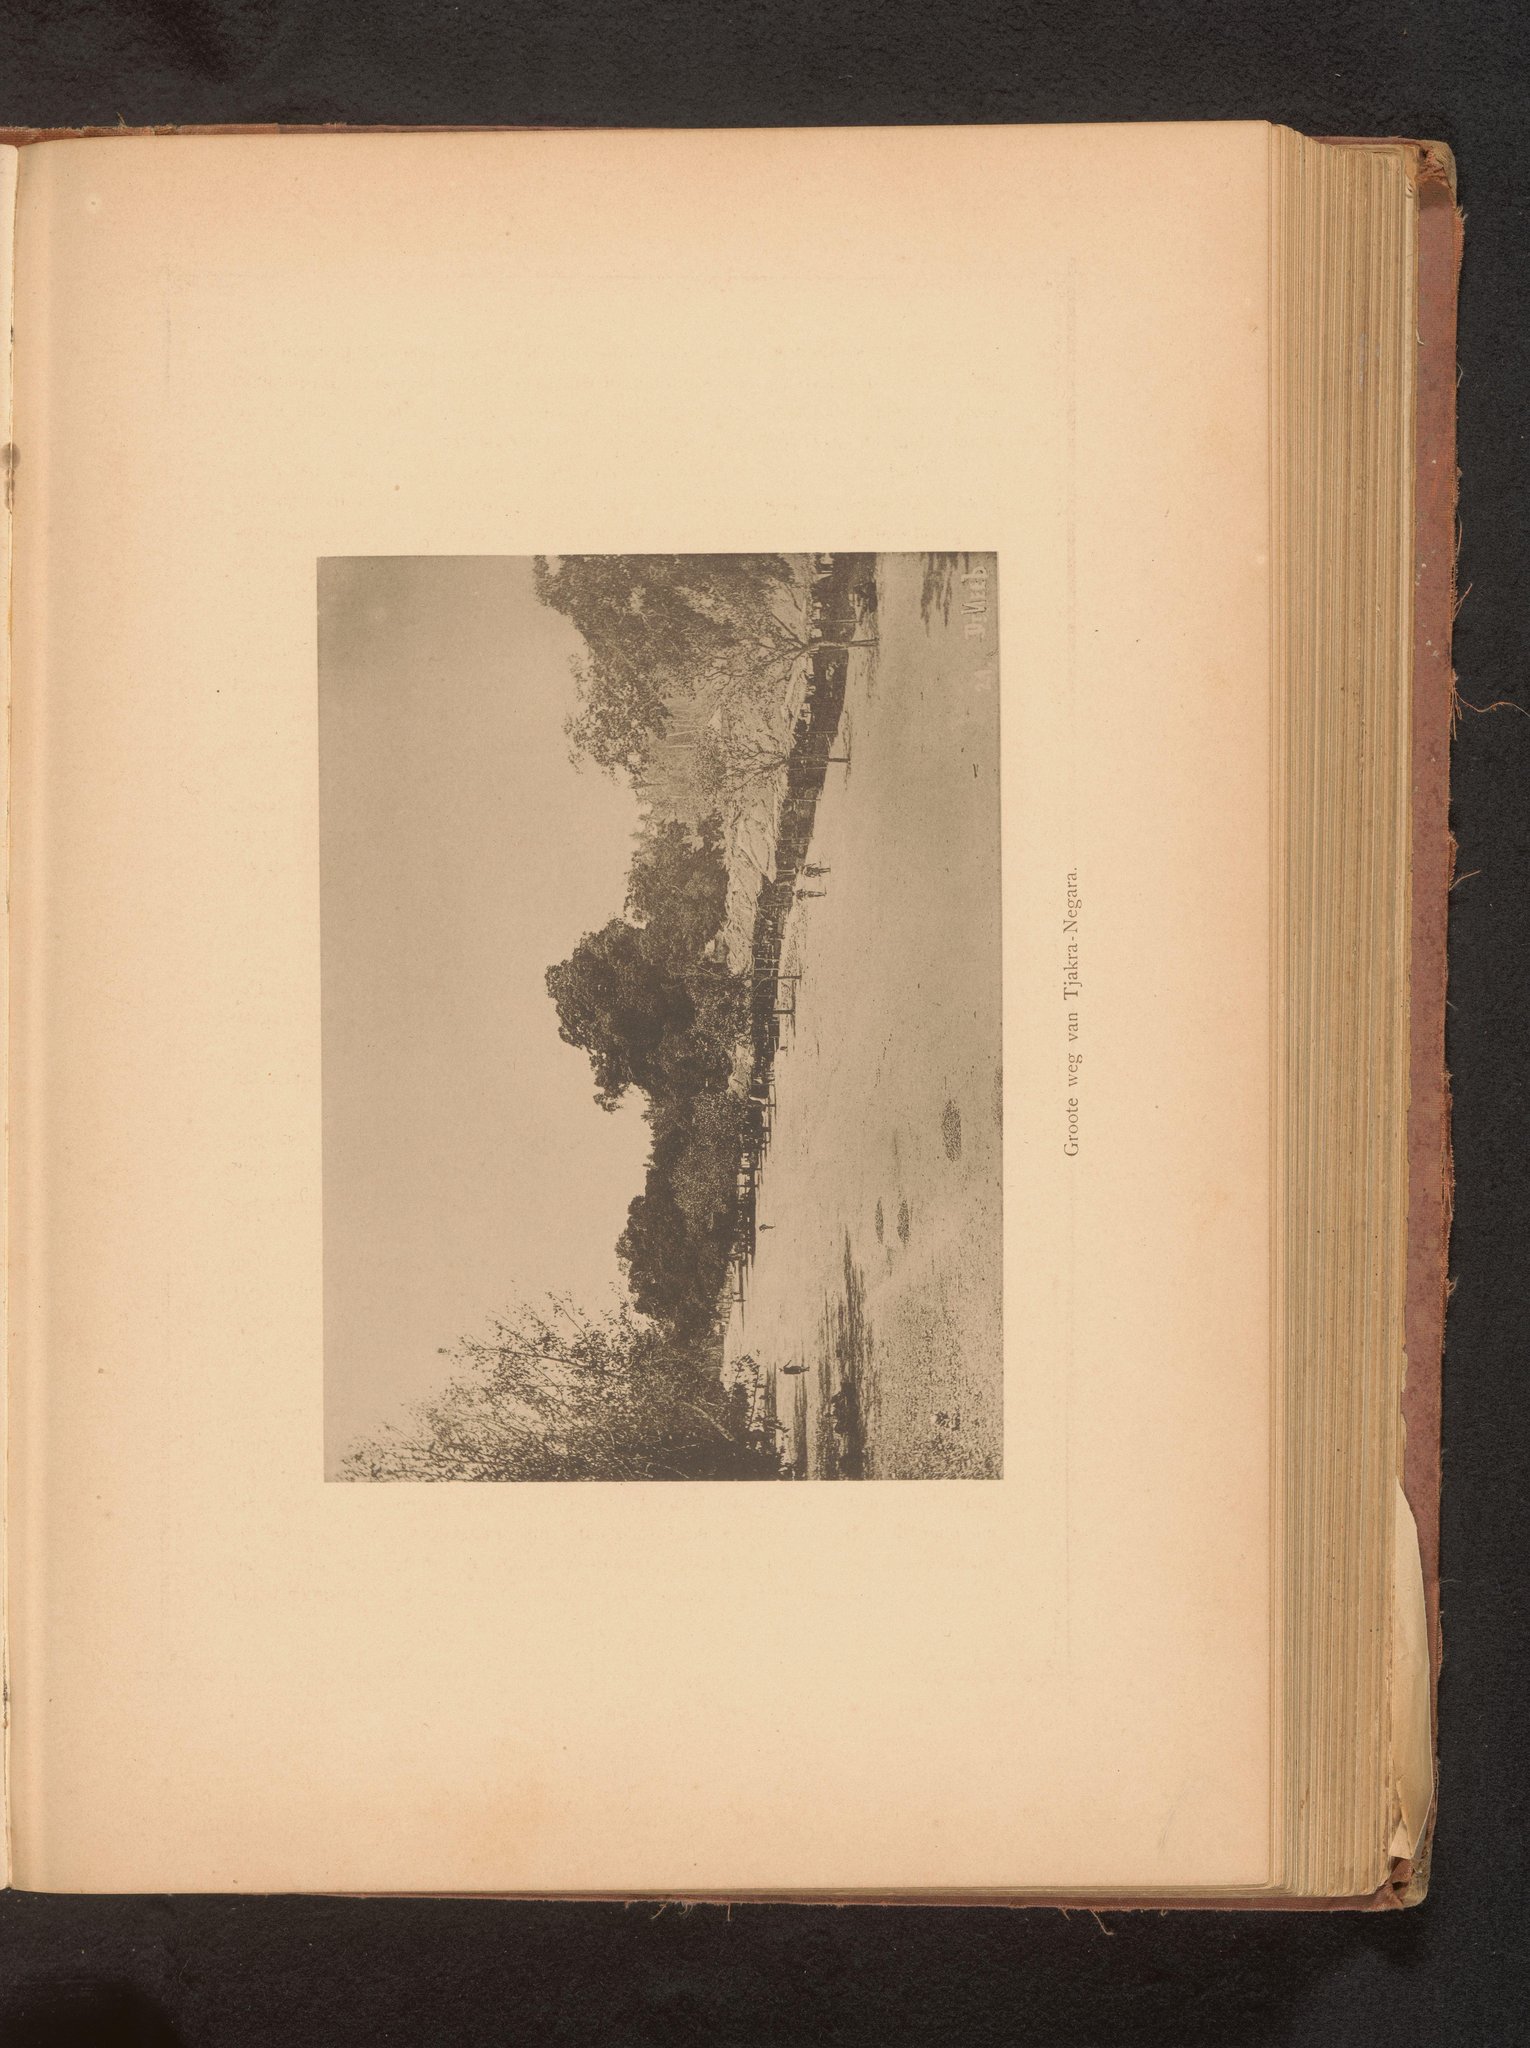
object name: page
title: Groote weg van Tjakra-Negara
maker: christiaan johan neeb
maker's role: arts, fotograaf, officier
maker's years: 1860-1925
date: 1892-1897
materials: paper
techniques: photograph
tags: road, path, indonesia